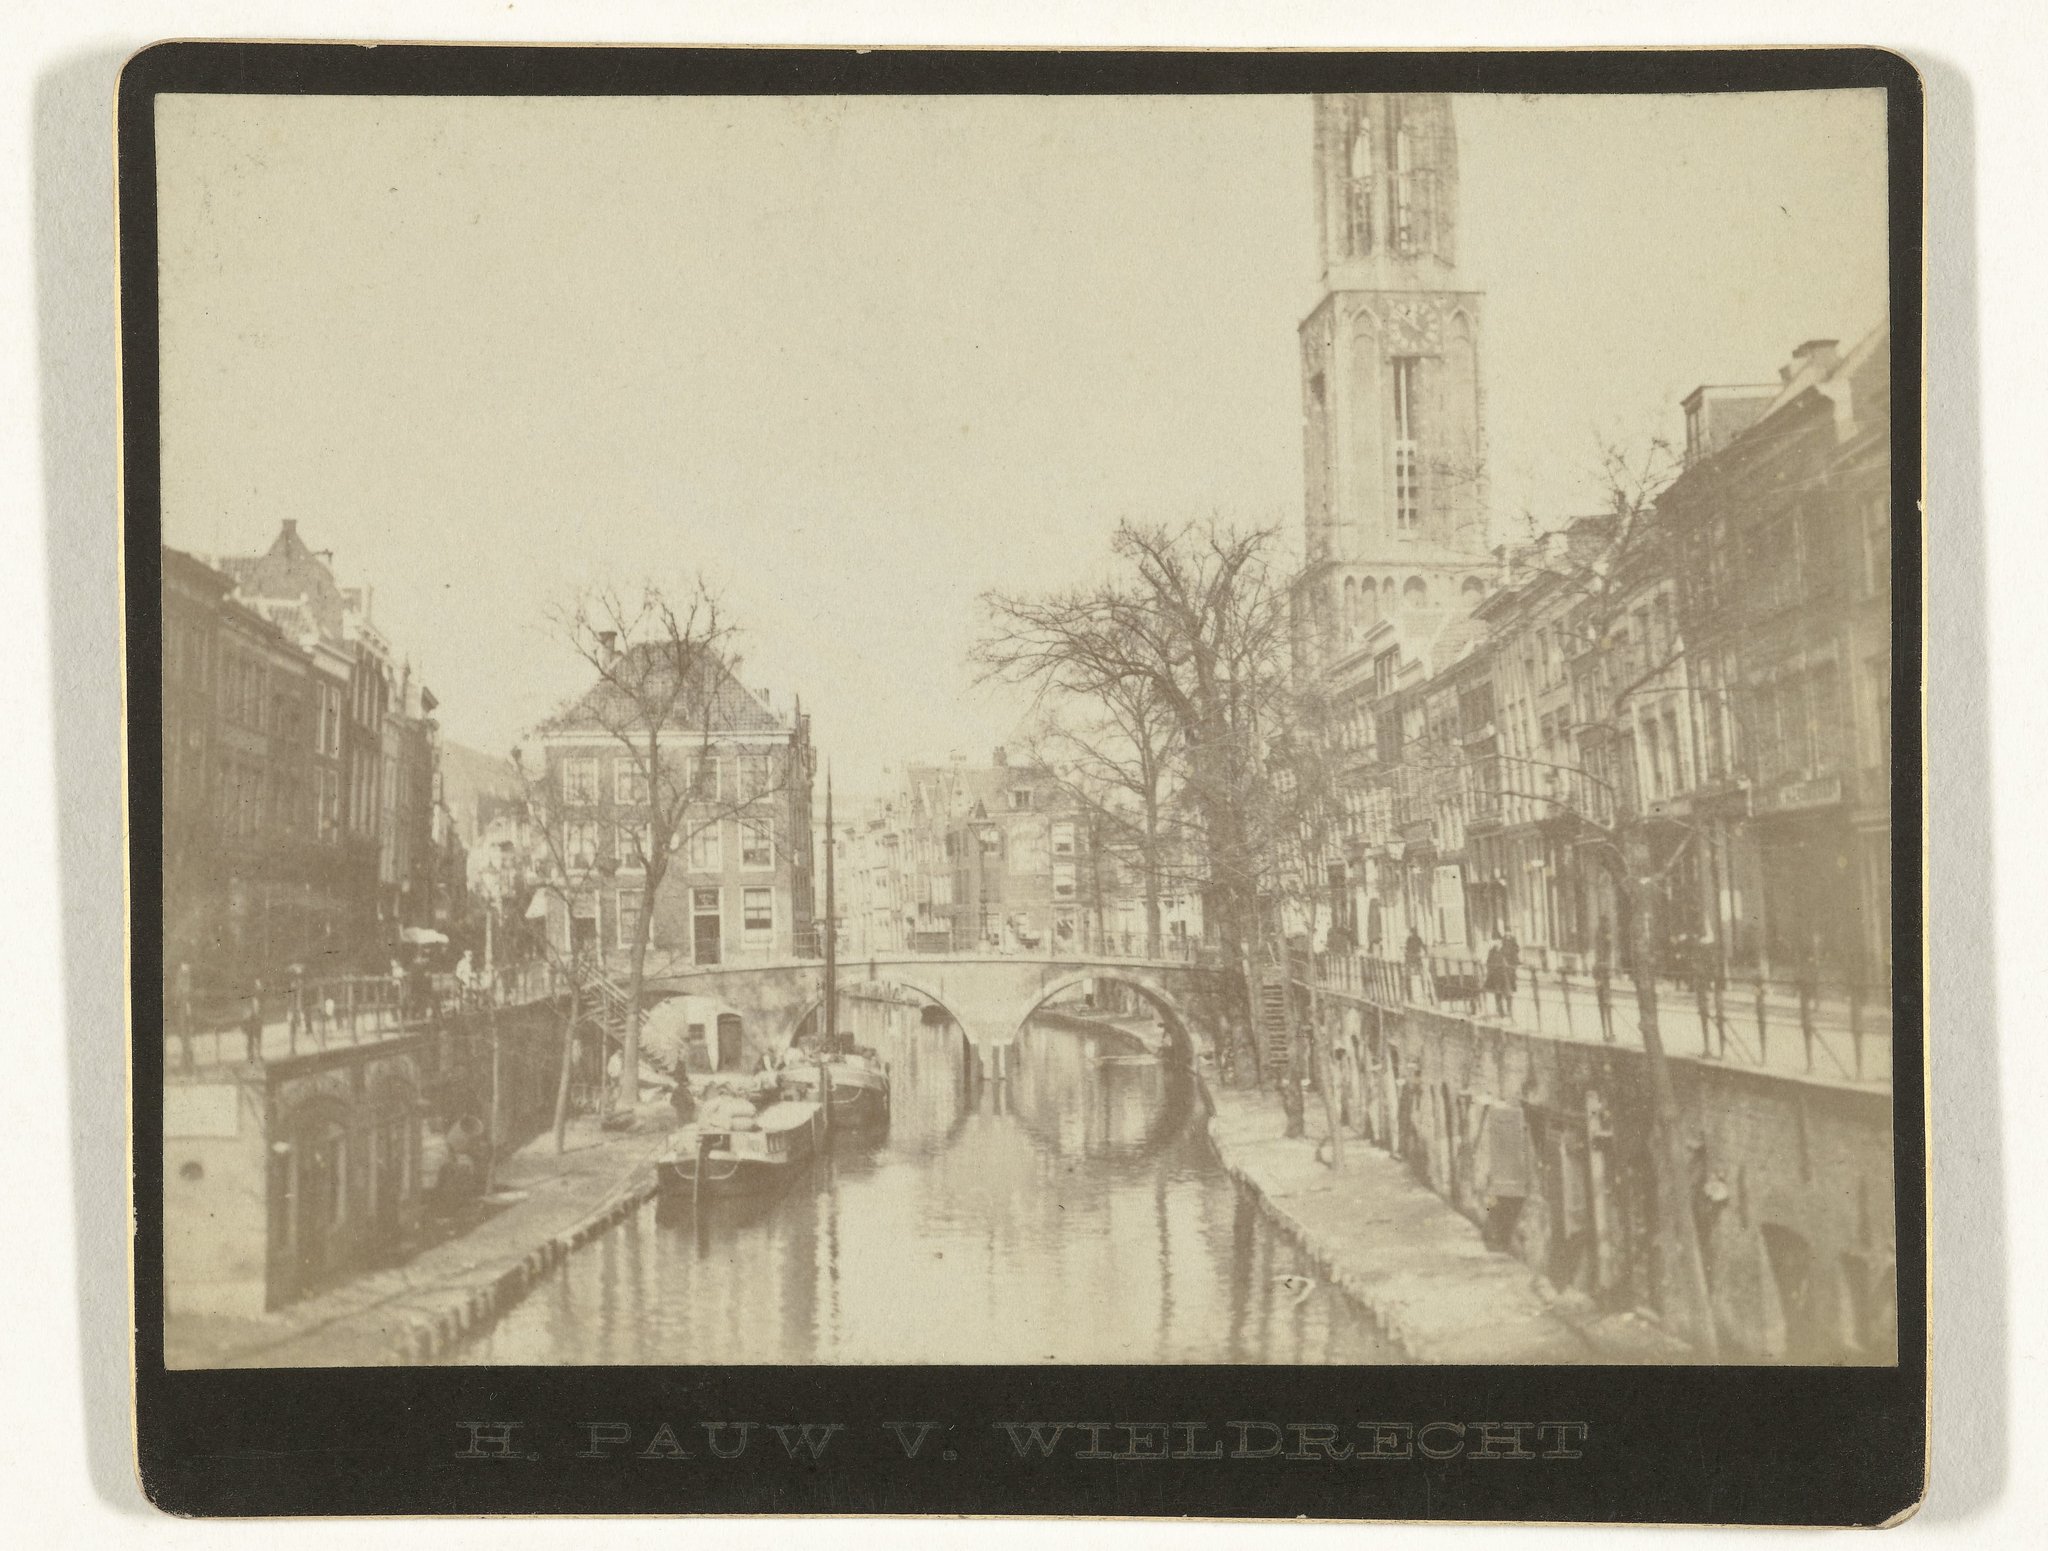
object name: photograph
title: Gezicht over de Oude Gracht te Utrecht, met de Domtoren op de achtergrond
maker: henry pauw van wieldrecht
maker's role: fotograaf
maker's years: 1863-1912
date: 1892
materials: cardboard, photographic support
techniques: albumen print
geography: netherlands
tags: oude gracht, domtoren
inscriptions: annotation: ‘No 24. 501. 1892’, signature: ‘H. PAUW V. WIELDRECHT’